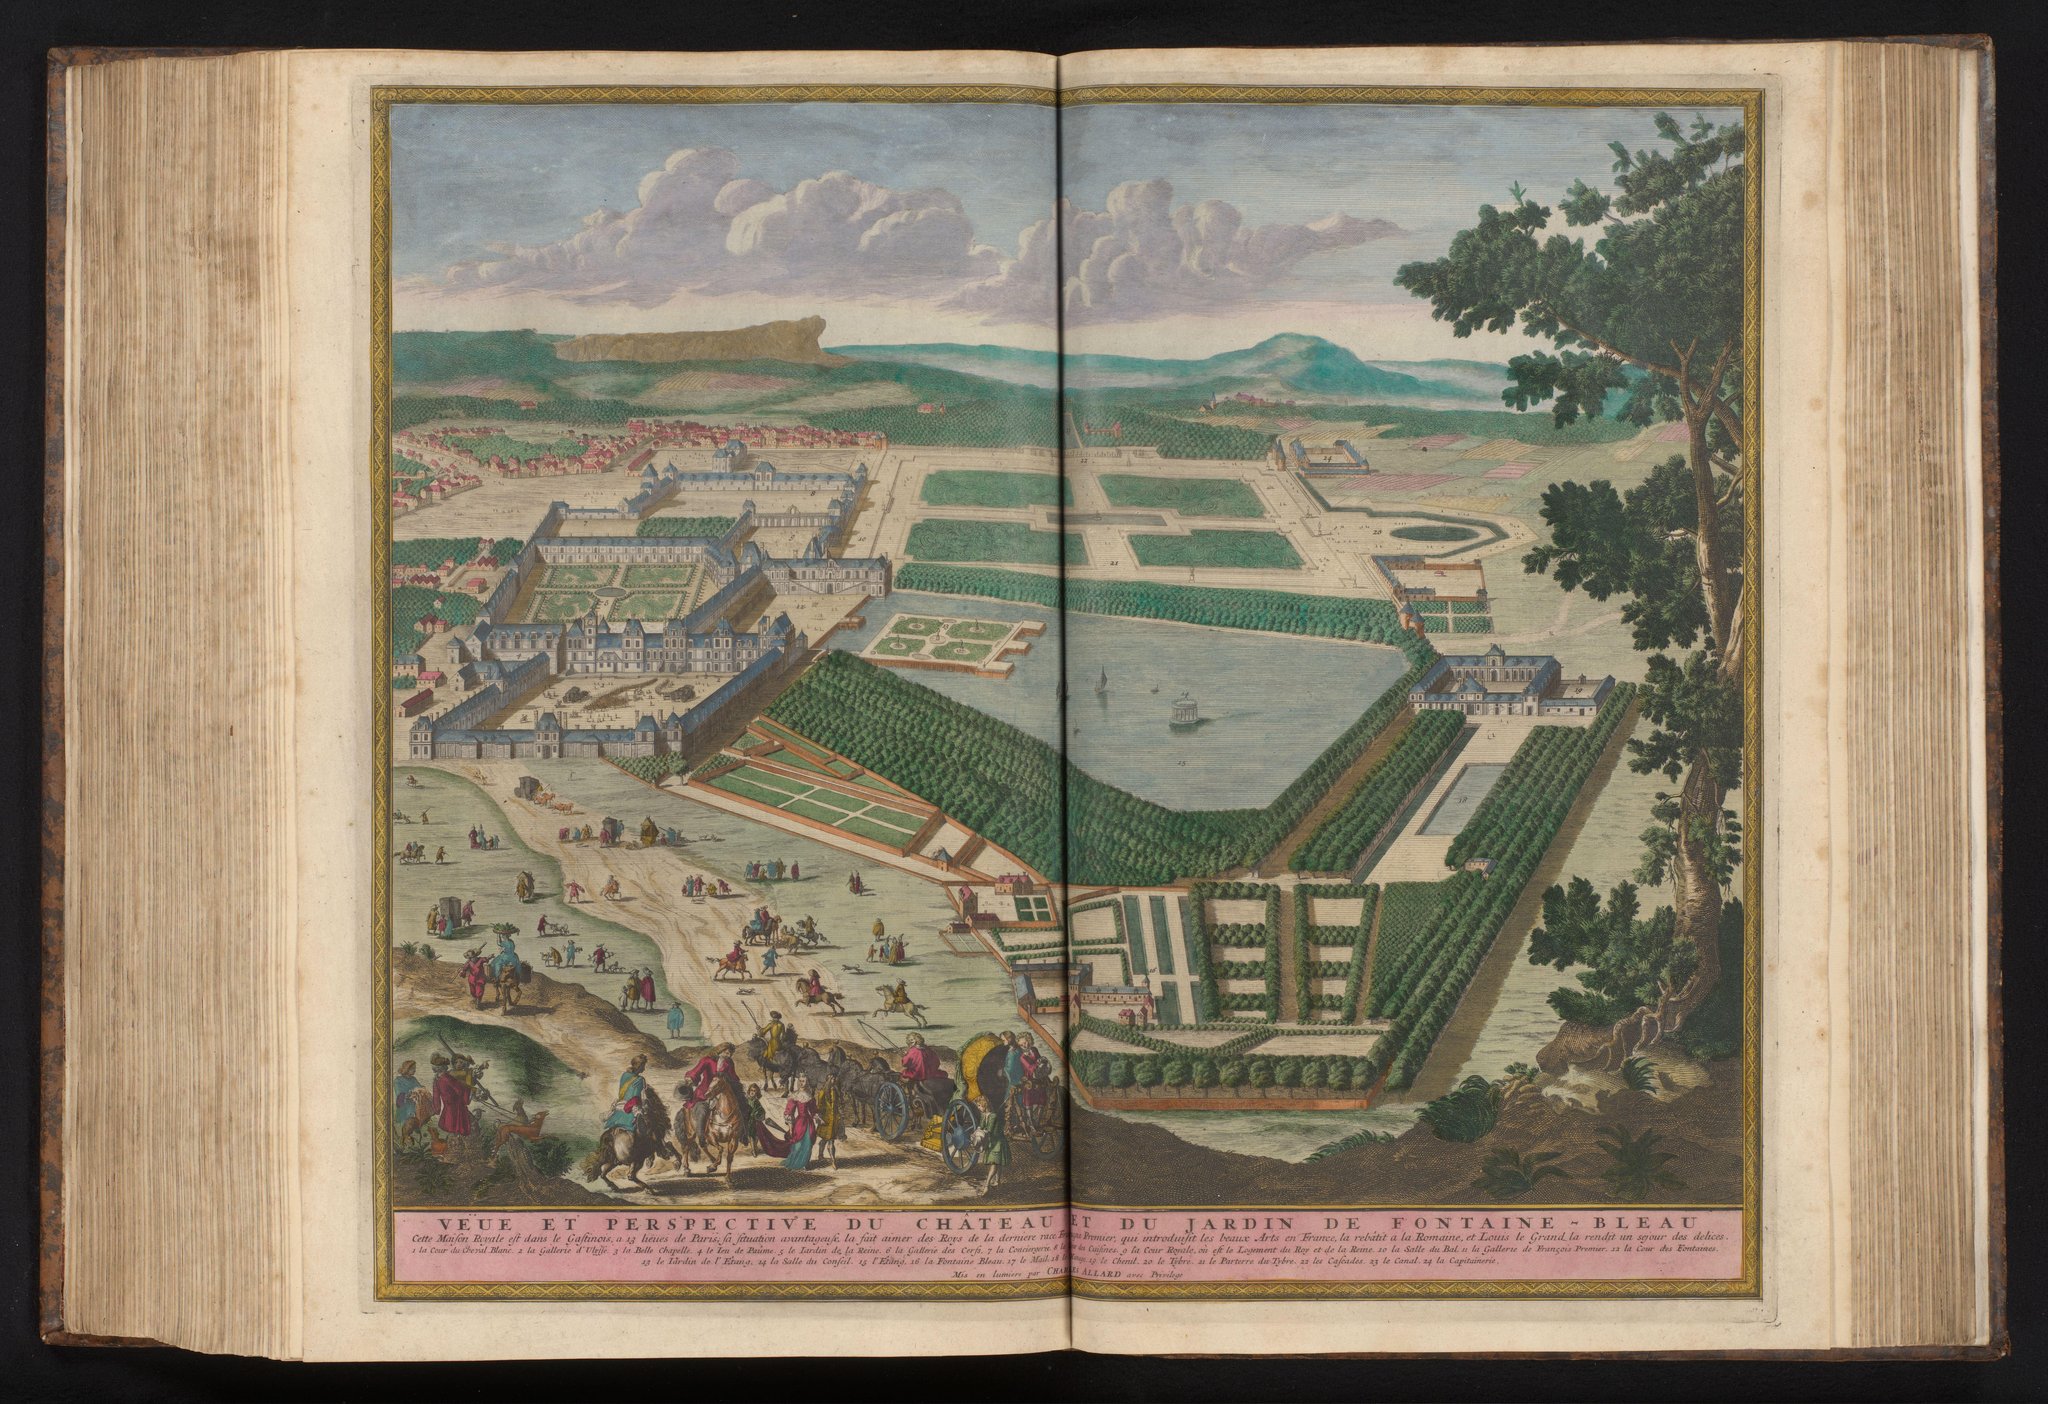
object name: print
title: Vëue et Perspective du Château et du Jardin de Fontaine-Bleau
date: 1673-1709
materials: paper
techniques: etching, hand coloring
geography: northern netherlands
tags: palace, french or architectonic garden; formal garden, bird's eye view ~ representation of building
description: Gezicht op het paleis en de tuinen van Fontainebleau. Onder de voorstelling een index in het Frans. Prent maakt deel uit van een album.